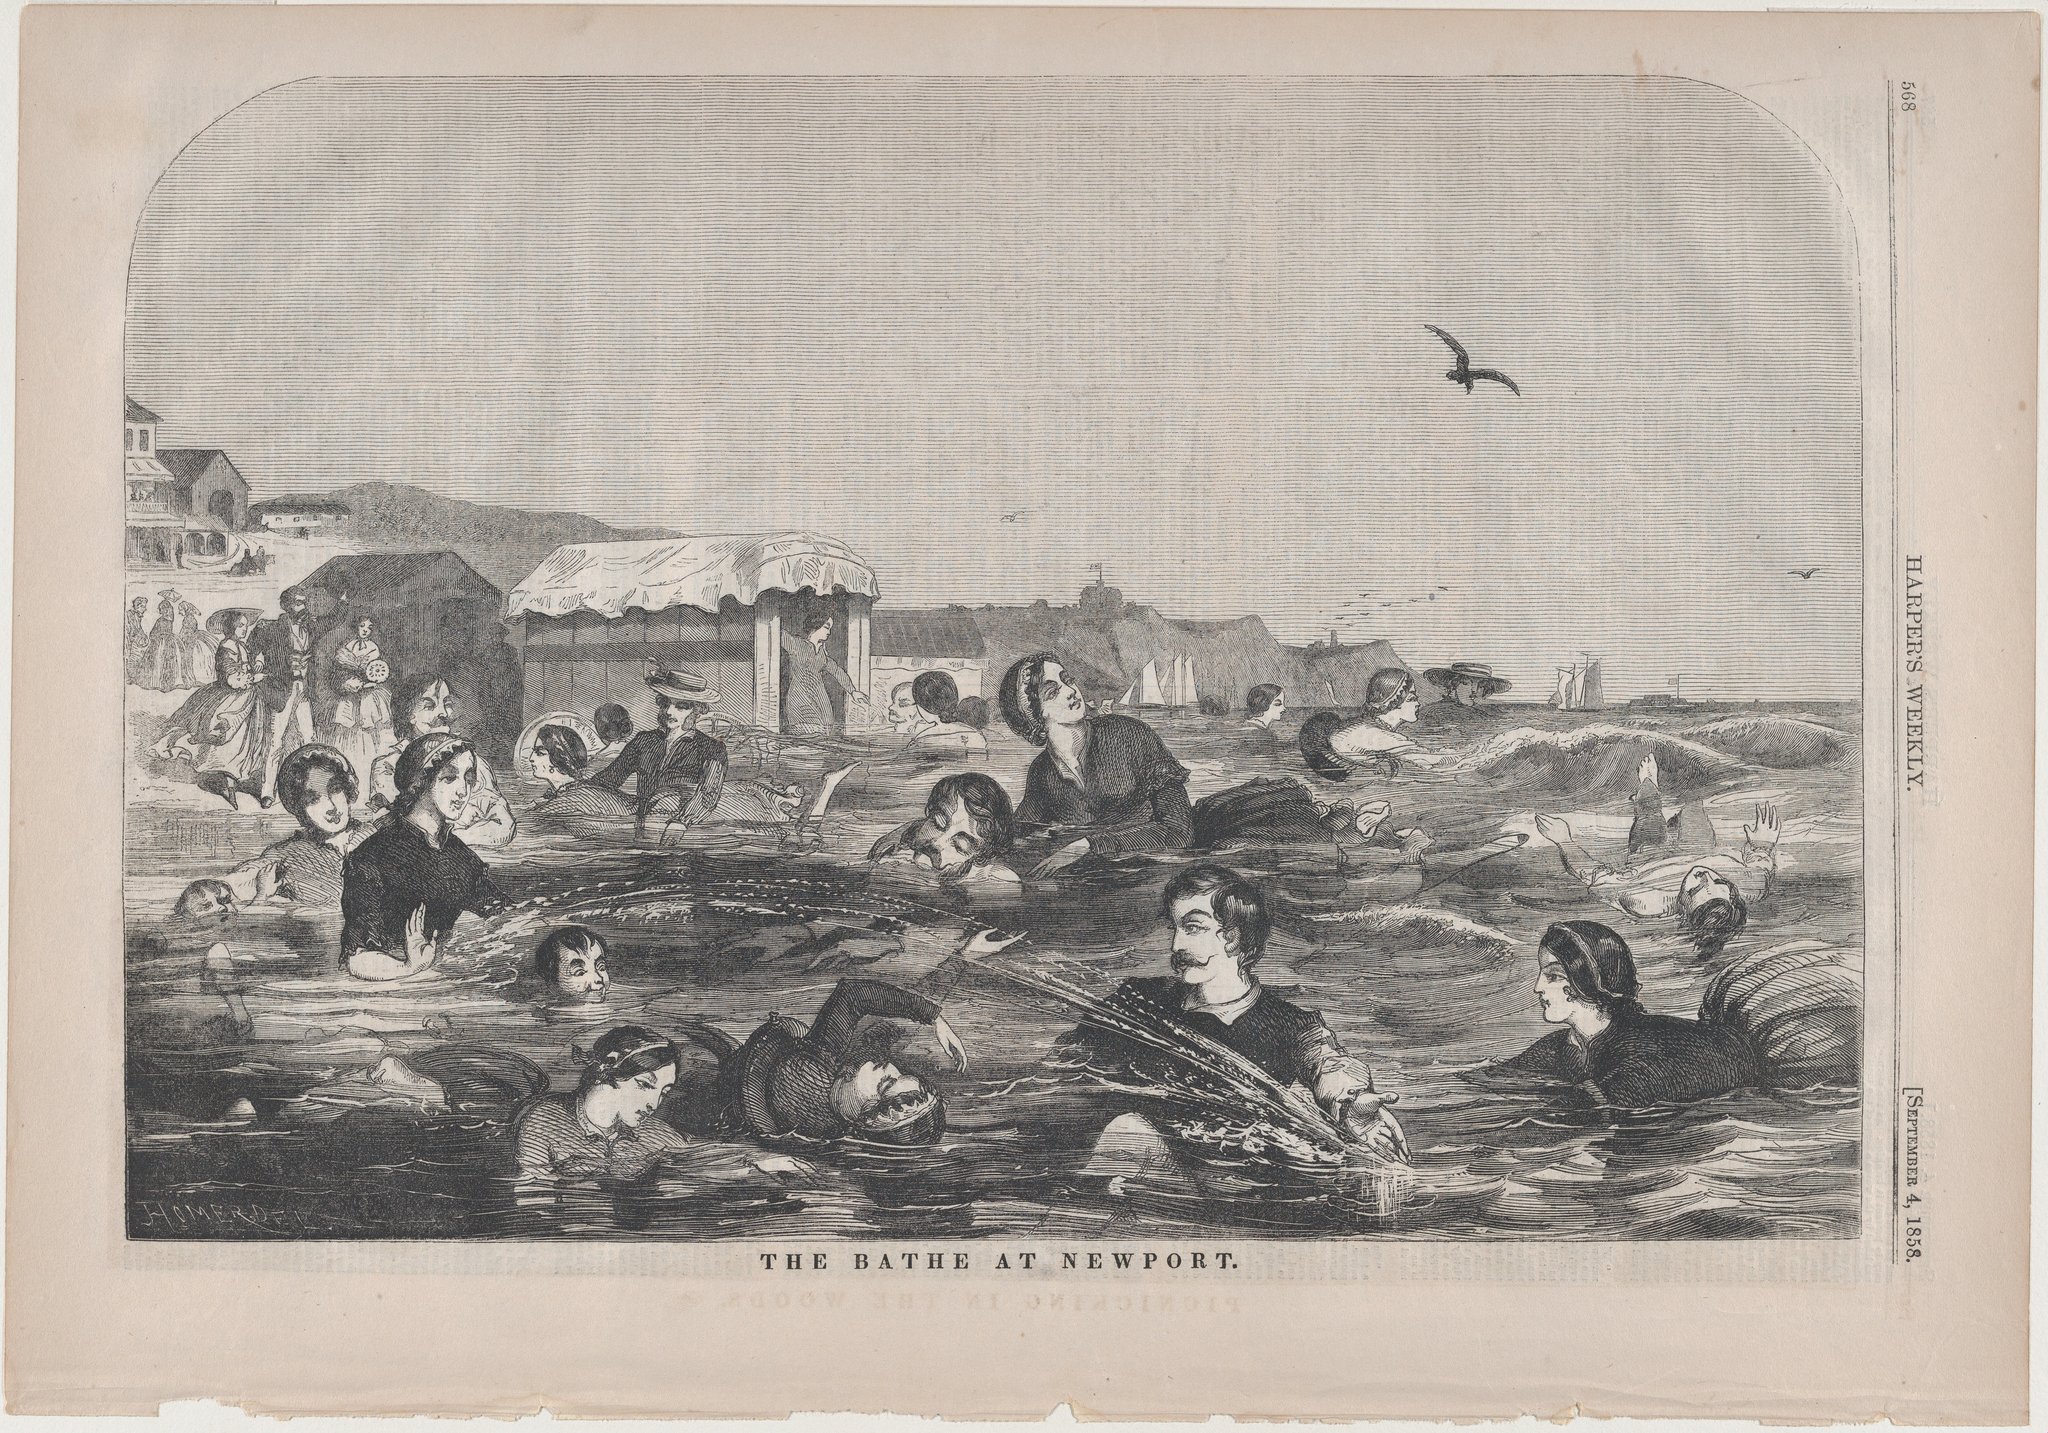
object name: print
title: The Bathe at Newport (from "Harper's Weekly," Vol. II)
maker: winslow homer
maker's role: artist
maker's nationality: american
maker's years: 1836-1910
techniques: engraving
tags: men,women,swimming